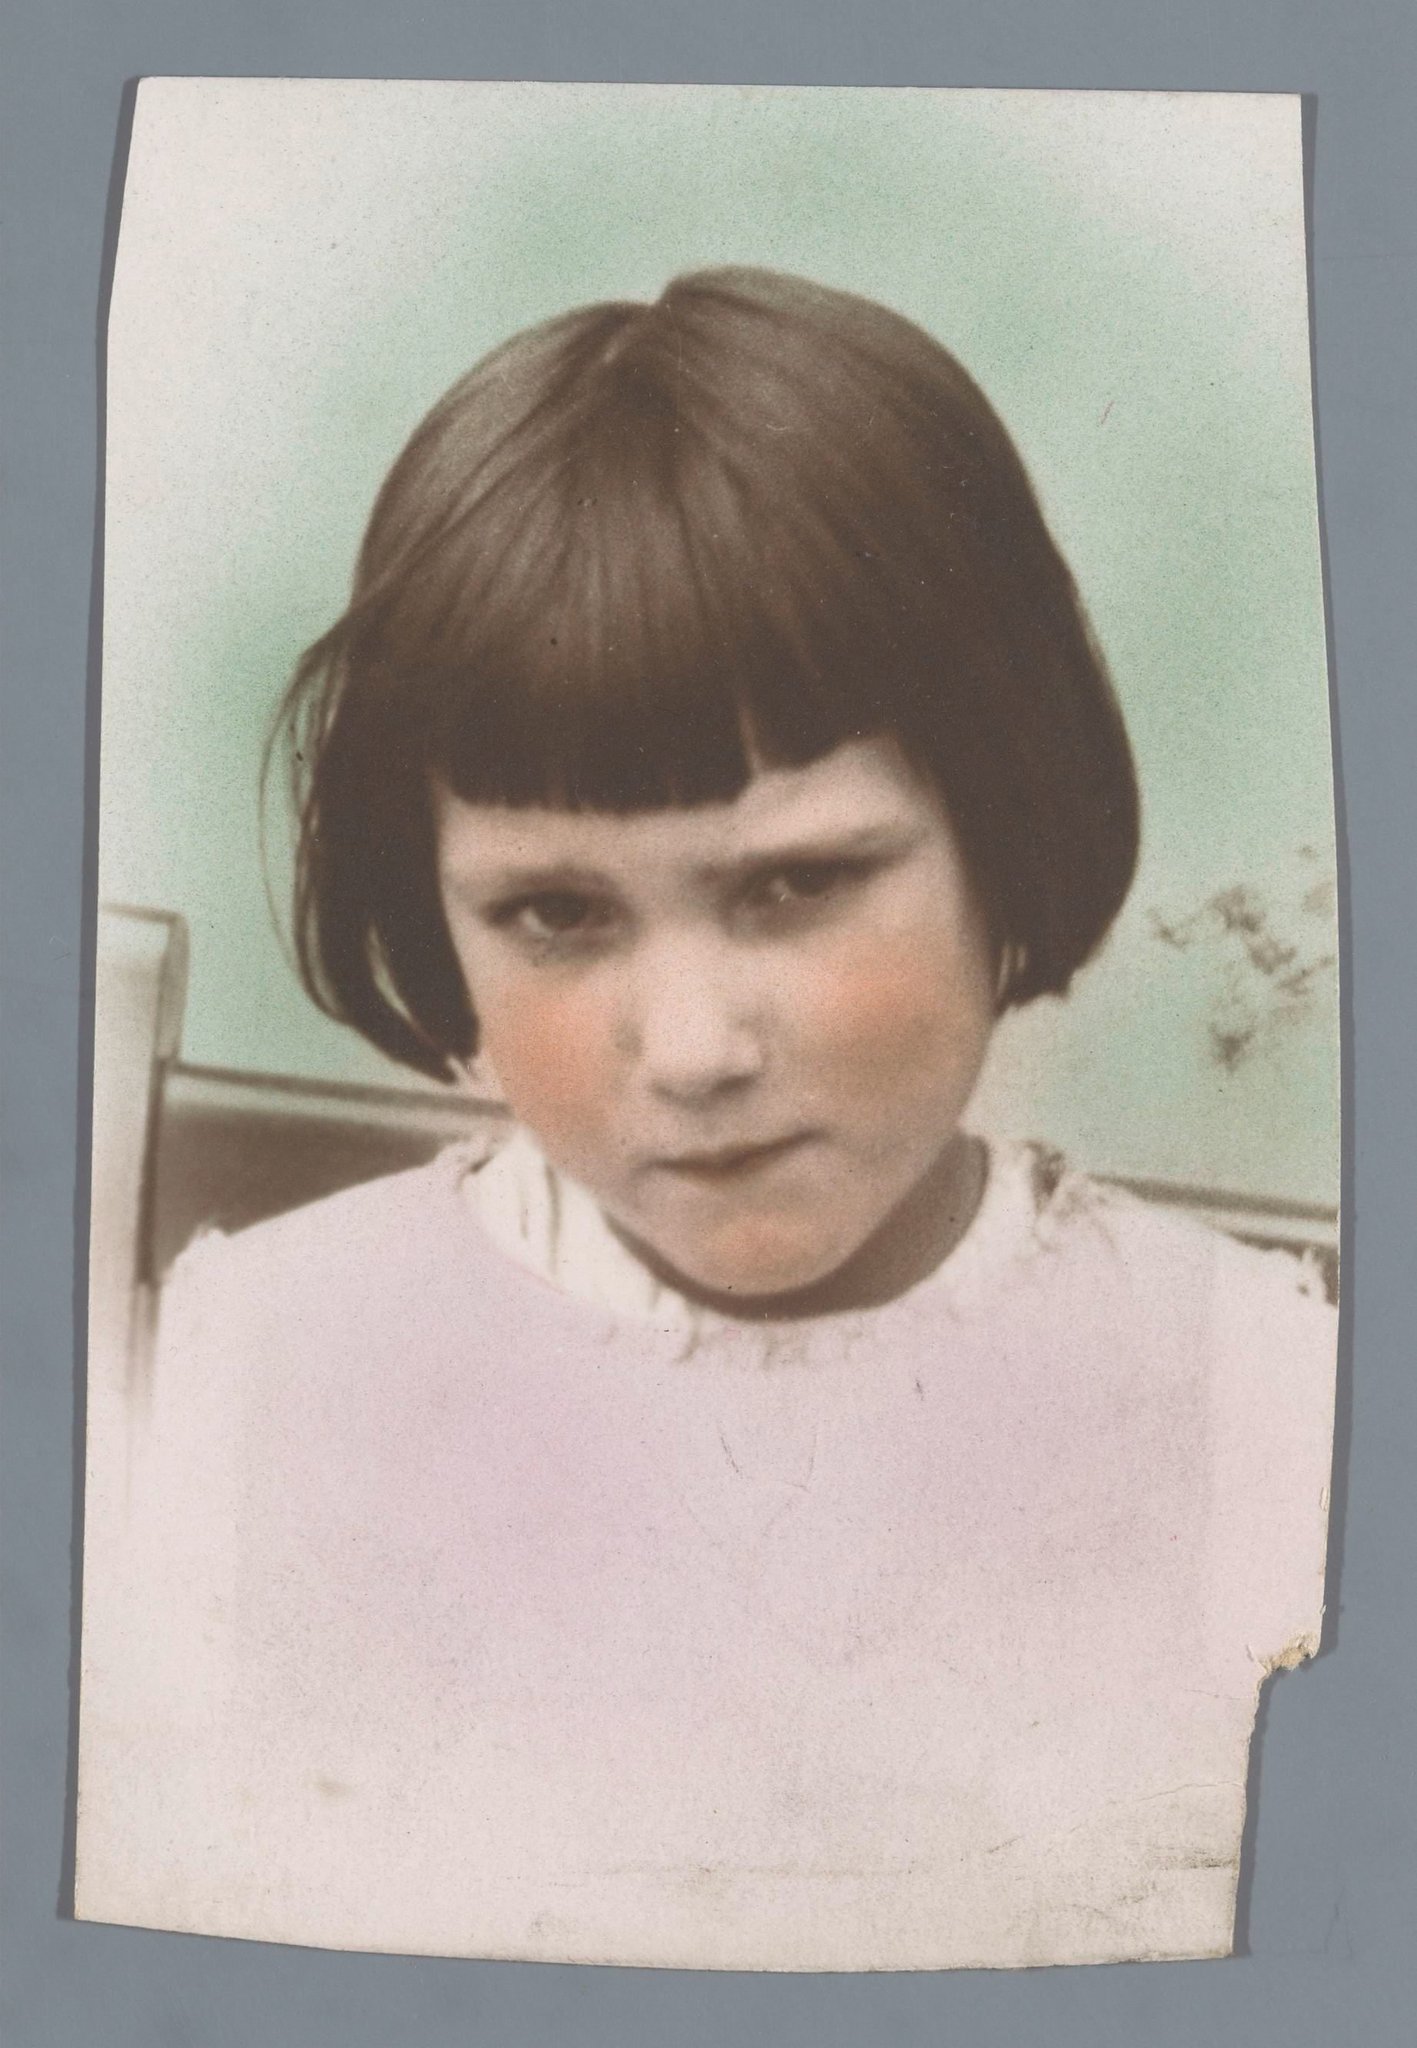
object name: photograph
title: Portret van een onbekend meisje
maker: Anonymous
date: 1905-1930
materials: photographic support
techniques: gelatin silver print, snipping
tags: child (at home) - aa - girl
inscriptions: number: ‘3610’